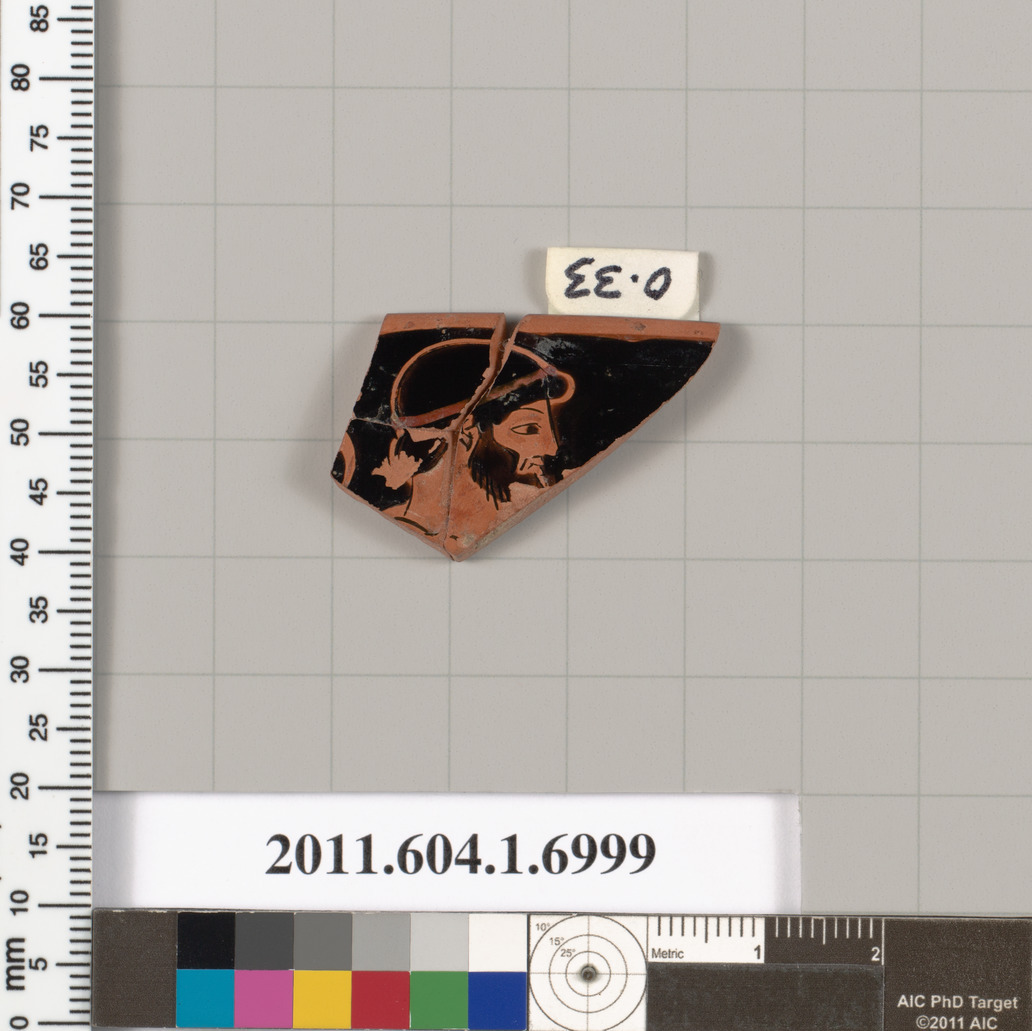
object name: kylix fragment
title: Terracotta rim fragment of a kylix (drinking cup)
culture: greek, attic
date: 500-490 BCE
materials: terracotta